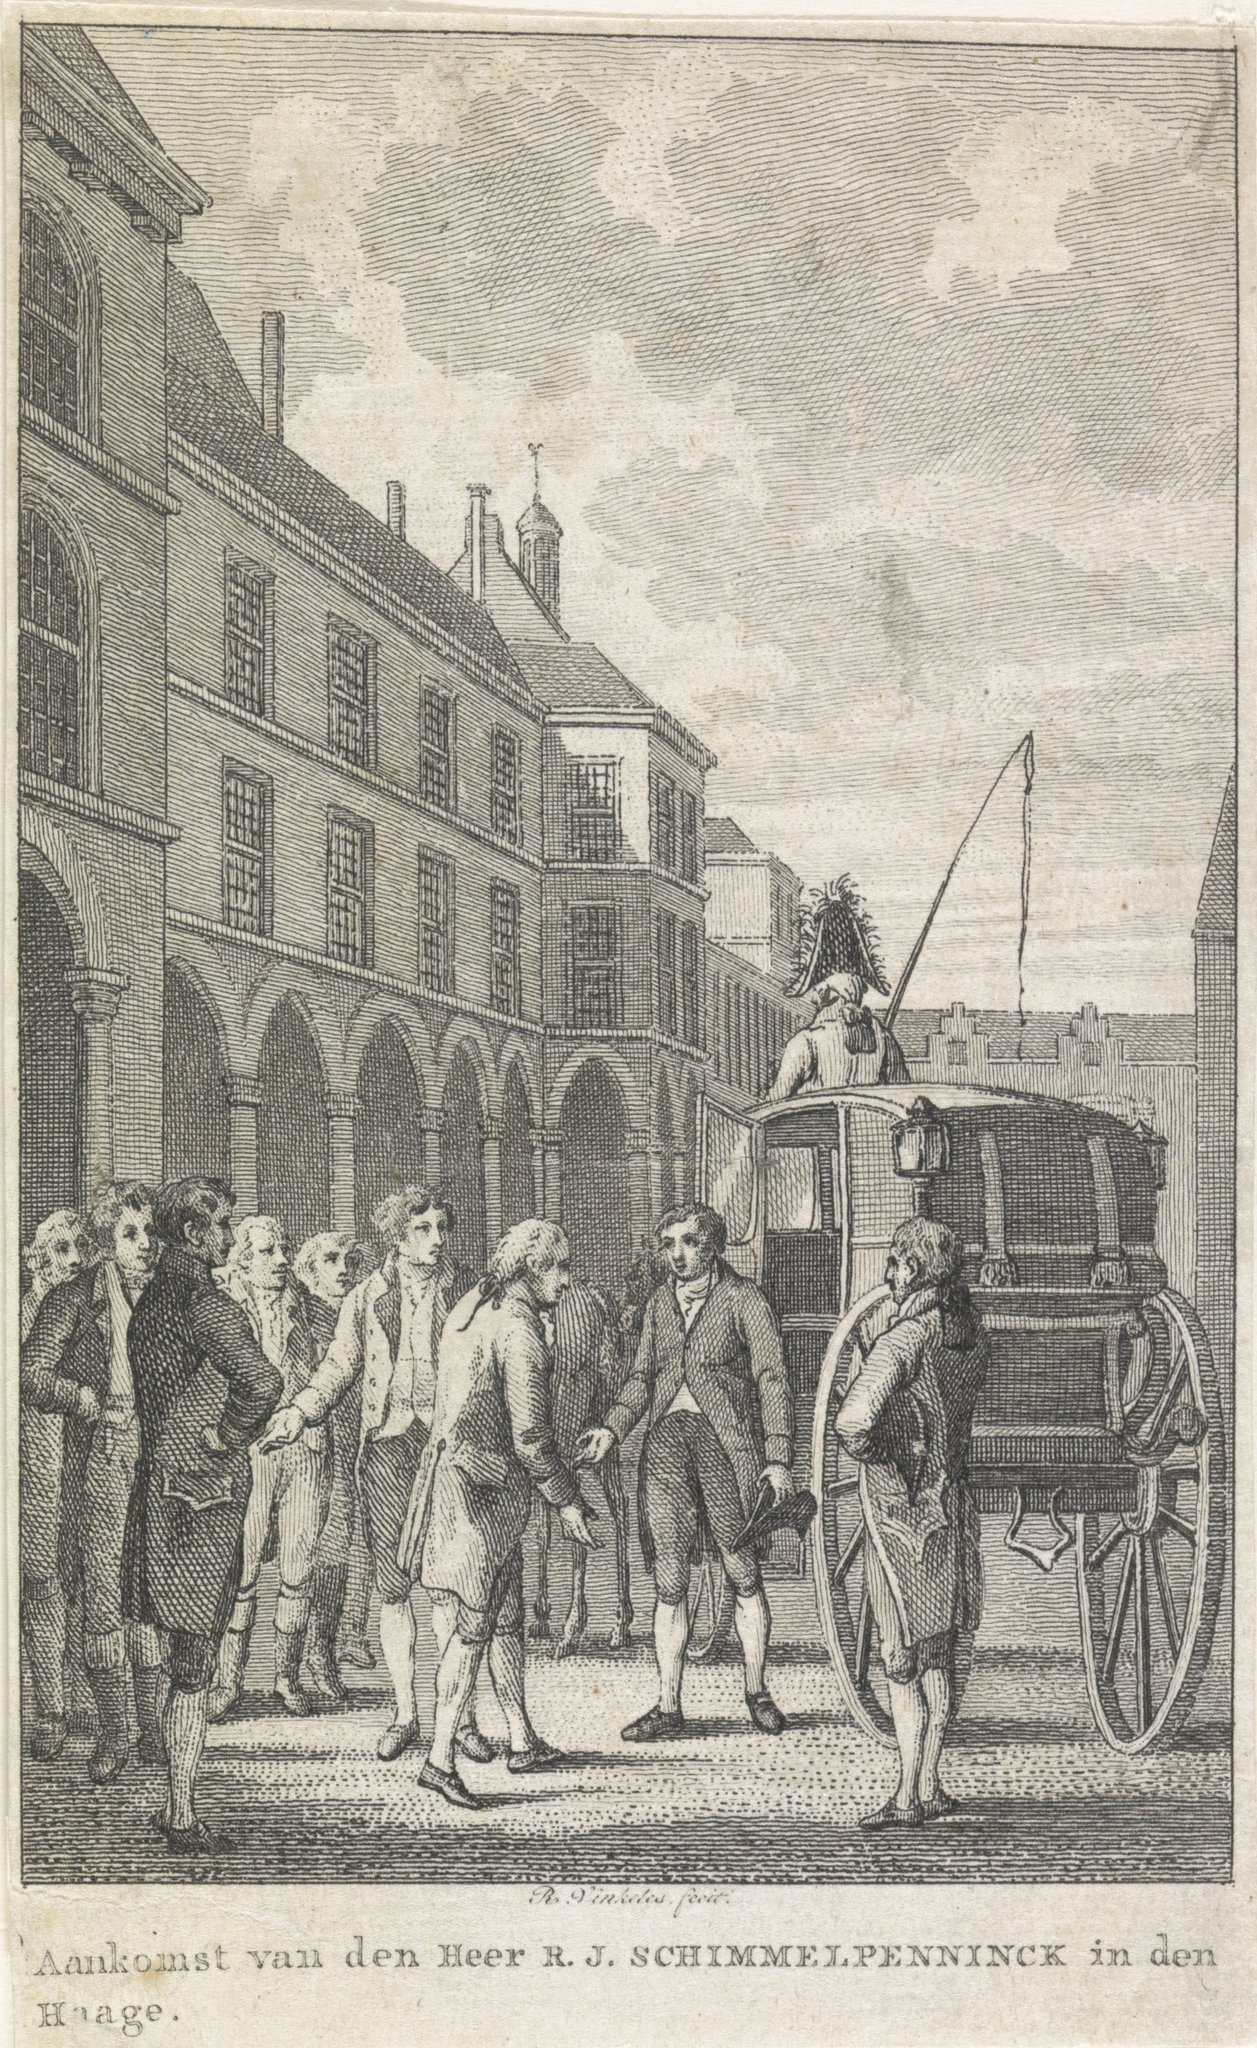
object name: print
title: Aankomst van R.J. Schimmelpenninck in Den Haag op 27 april 1805 als raadpensionaris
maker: reinier vinkeles (i)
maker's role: draughtsman, print maker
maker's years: 1741-1816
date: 1805-1812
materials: paper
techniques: engraving, etching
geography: netherlands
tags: deventer, amsterdam, rutger jan schimmelpenninck (1761-1825), being welcomed ~ travelling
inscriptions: collector's mark: Lugt 2228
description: Aankomst van Mr. R.J. Schimmelpenninck in Den Haag op 27 april 1805 als raadpensionaris van het Bataafs Gemenebest. Hij wordt bij het verlaten van zijn rijtuig op het Binnenhof opgewacht en begroet.